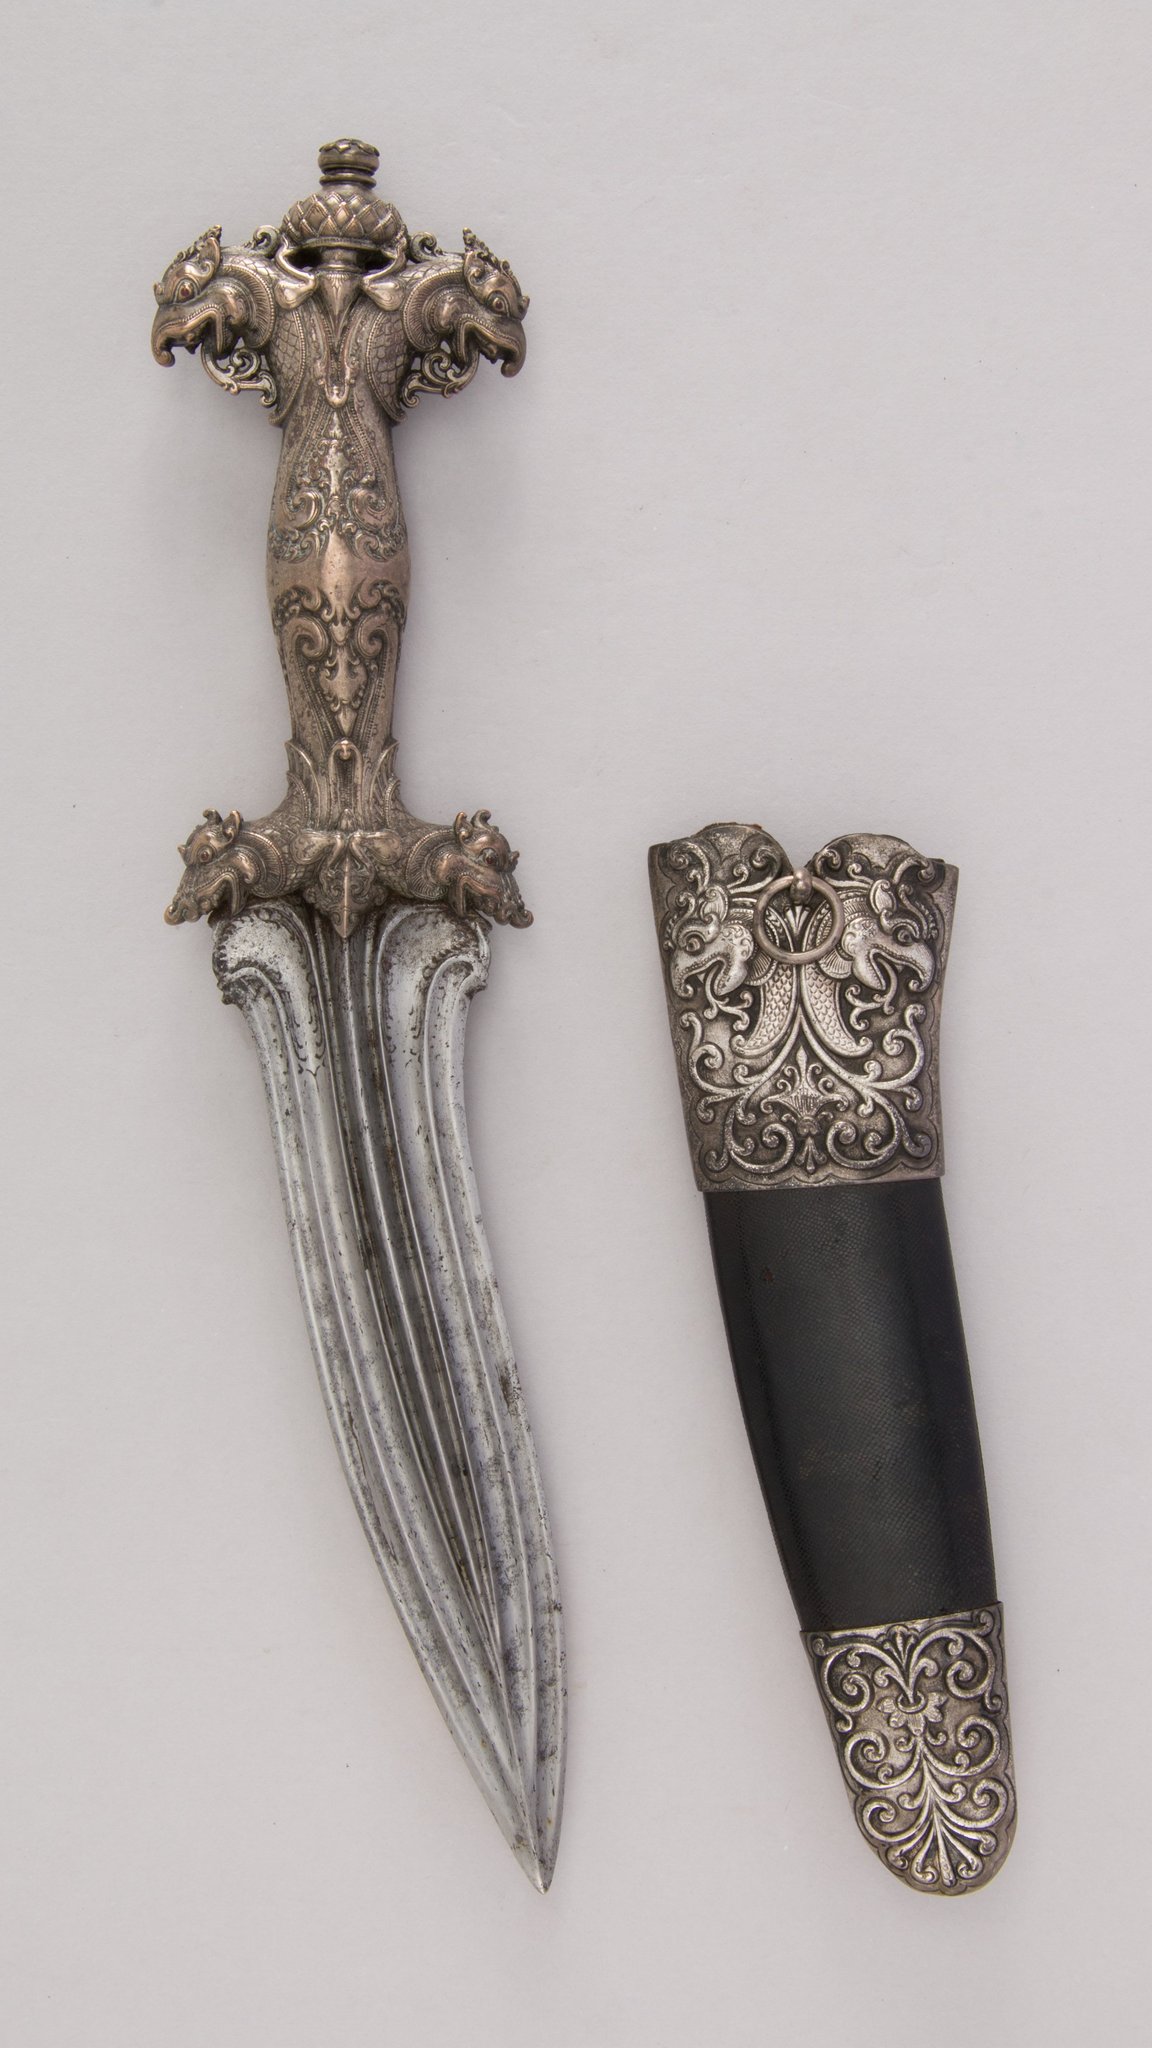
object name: dagger with sheath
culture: sri lankan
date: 1700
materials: silver, skin, steel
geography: sri lanka